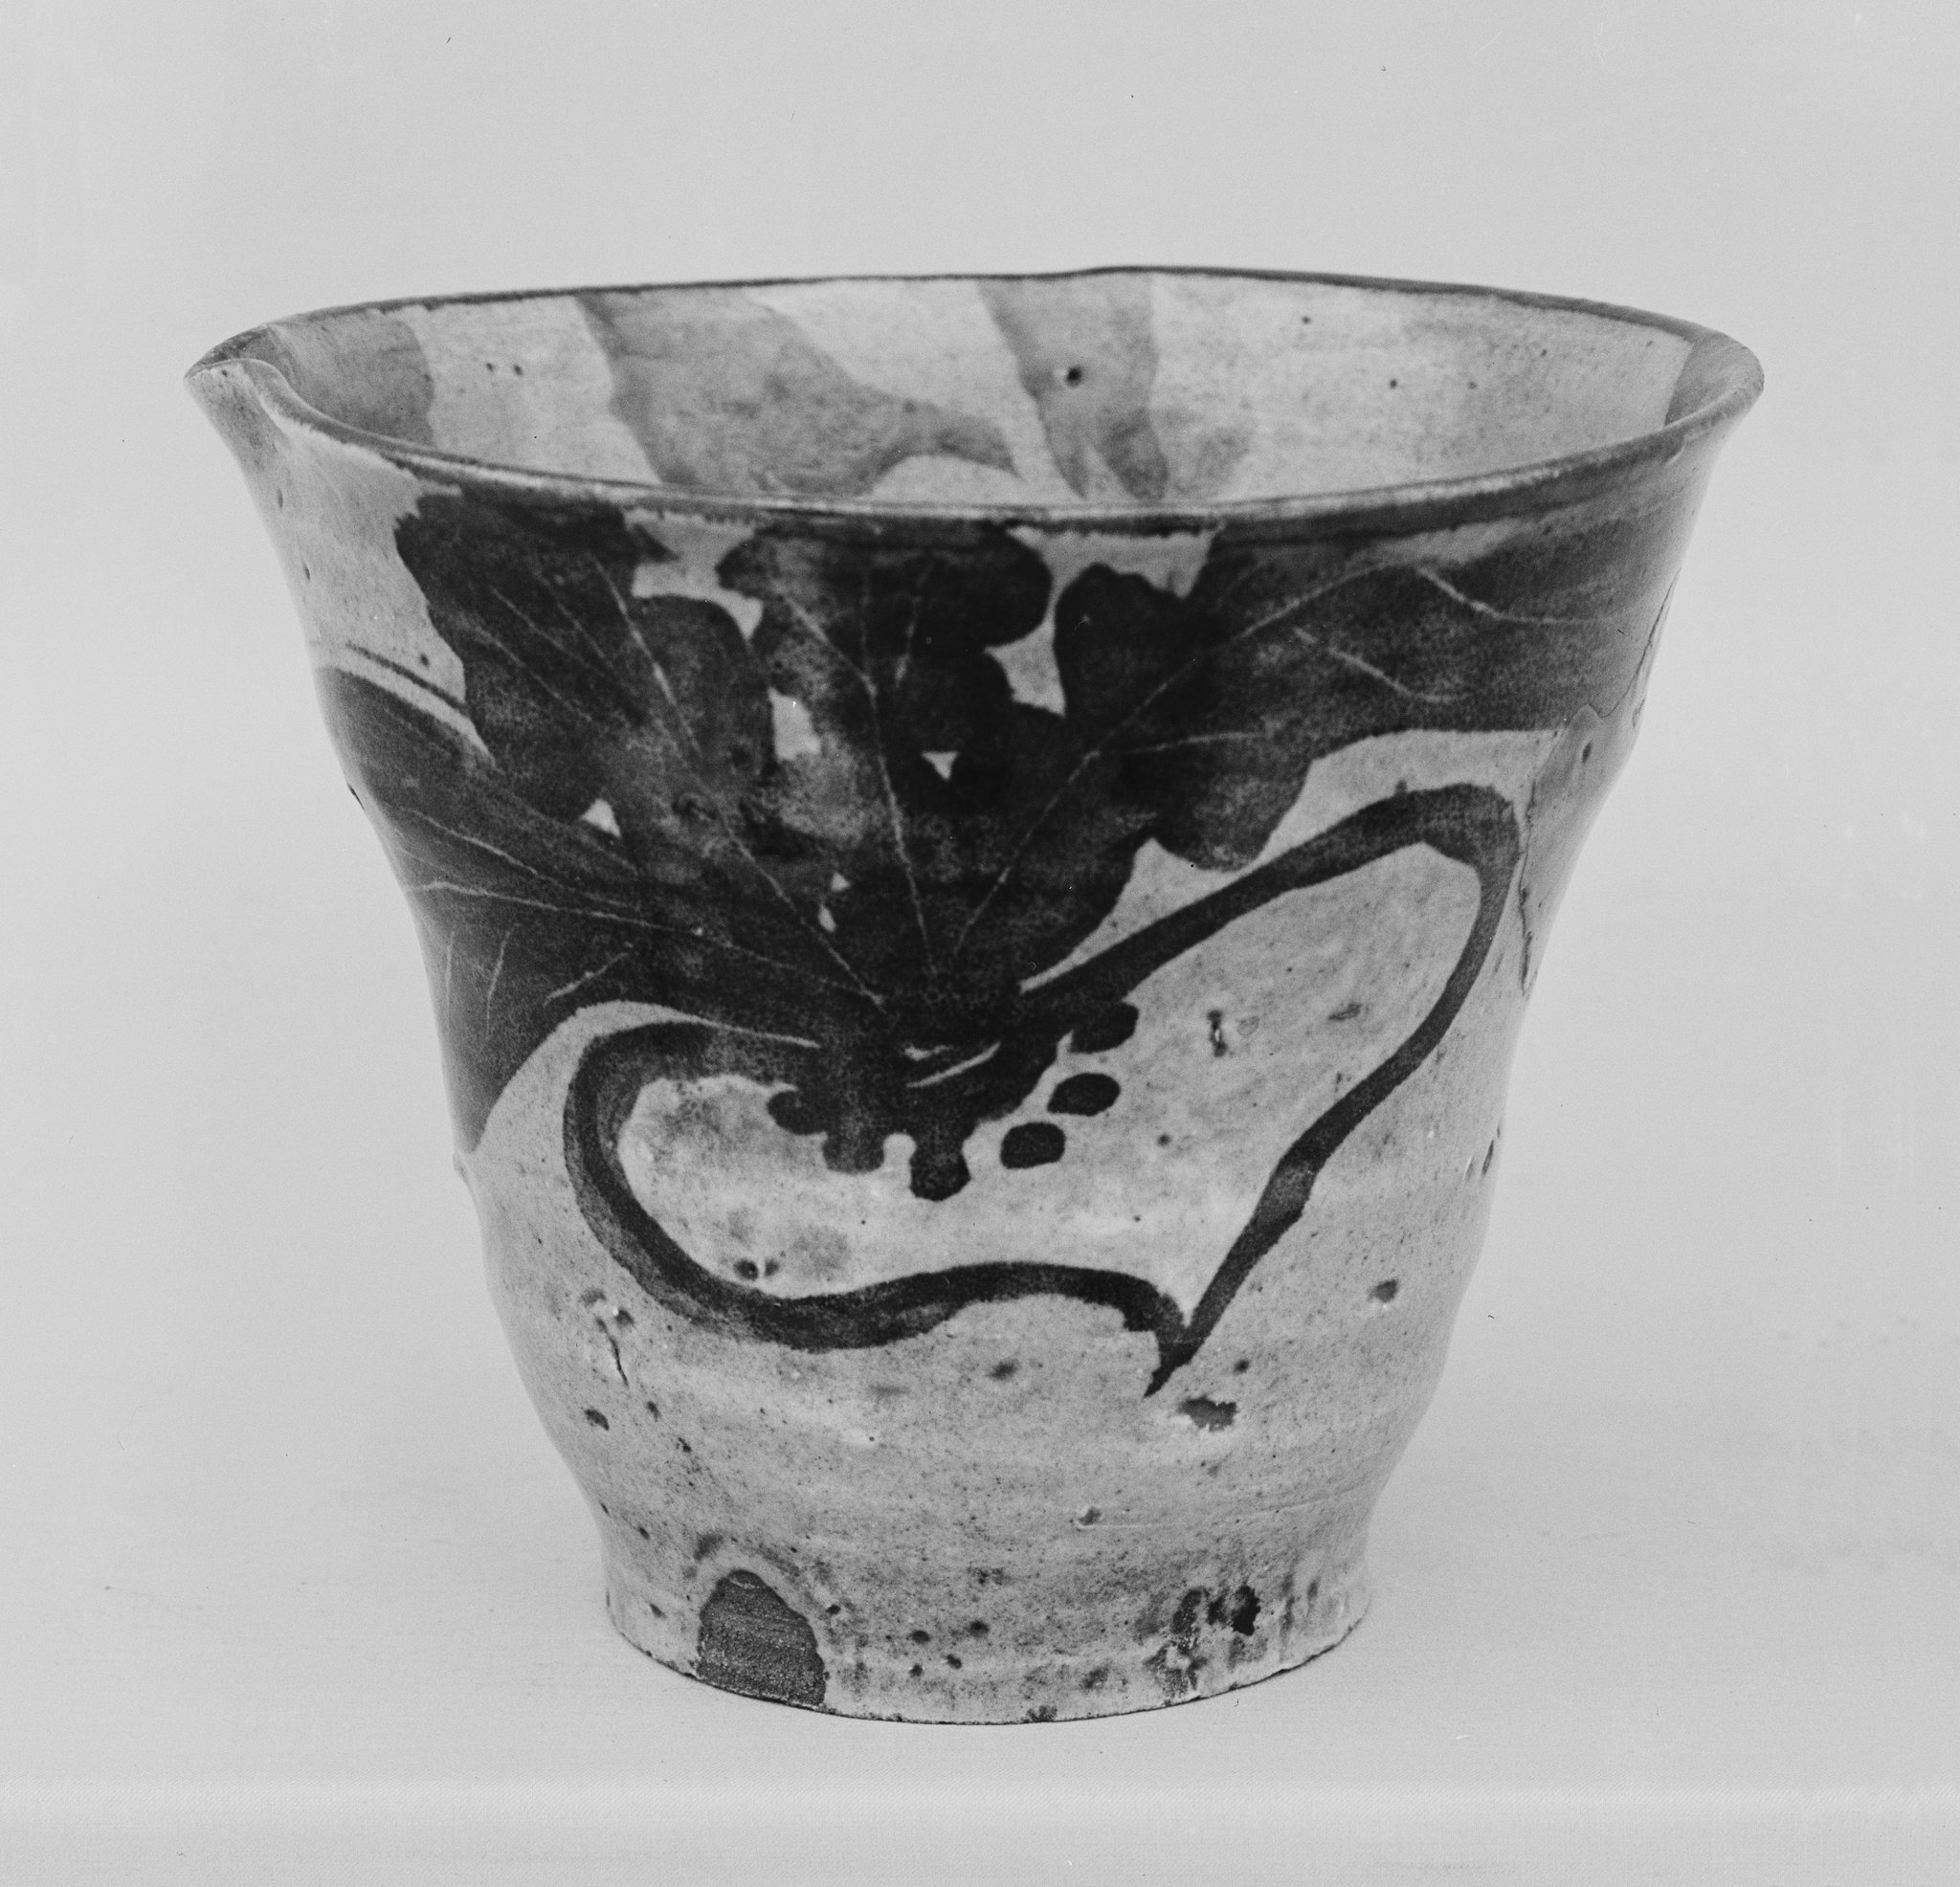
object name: cup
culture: japanese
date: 1701-1800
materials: clay, glaze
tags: leaves